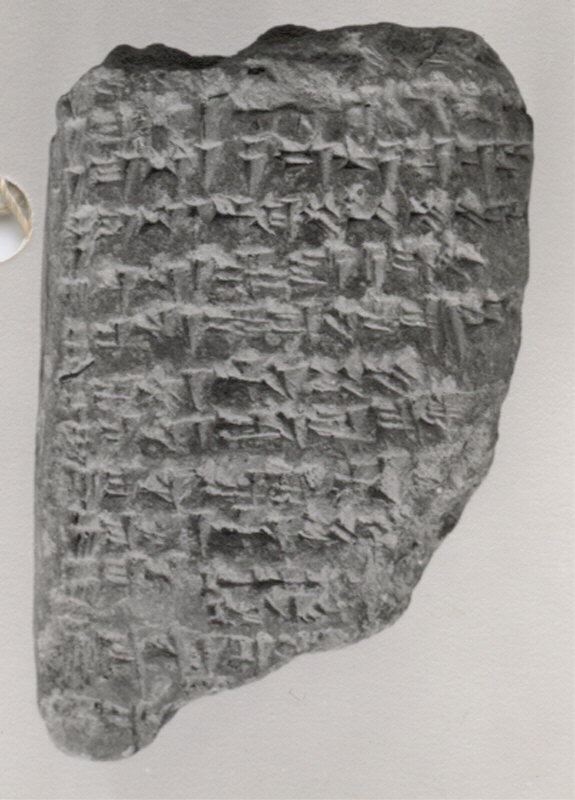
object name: cuneiform tablet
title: Cuneiform tablet: wool expenditures to personnel, Ebabbar archive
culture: babylonian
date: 626-605 BCE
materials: clay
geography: mesopotamia